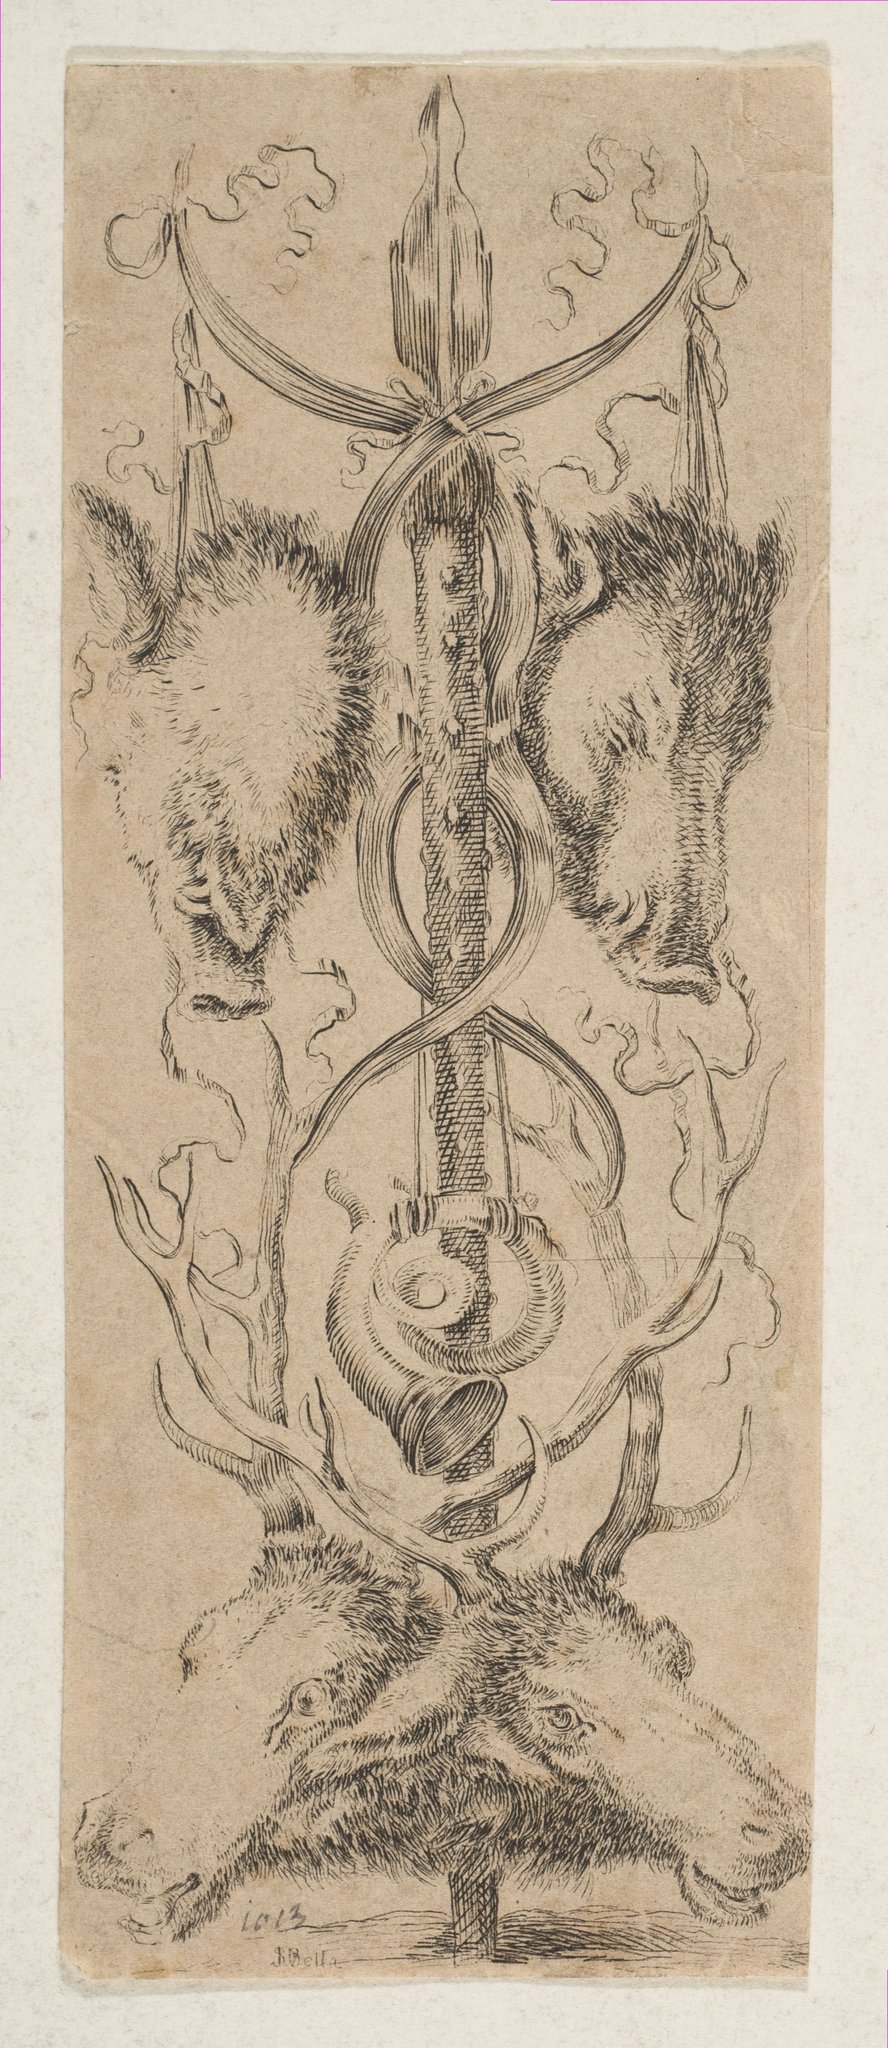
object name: print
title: Hunting Trophy with Stag Heads at Bottom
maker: stefano della bella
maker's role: artist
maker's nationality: italian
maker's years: 1610-1664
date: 1653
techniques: etching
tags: weapons,deer